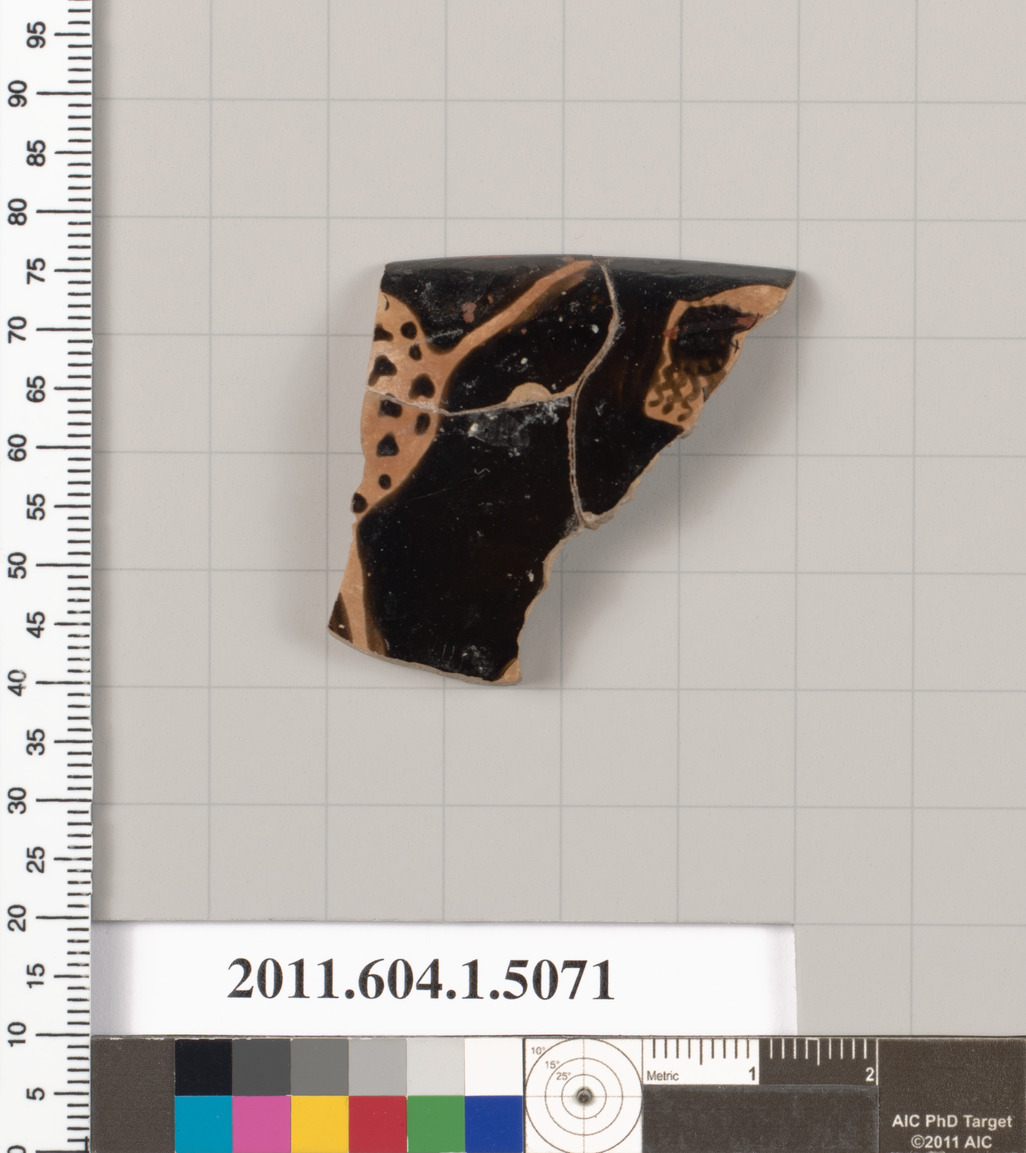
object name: kylix fragment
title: Terracotta rim fragment of a kylix (drinking cup)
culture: greek, attic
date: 475-451 BCE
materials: terracotta